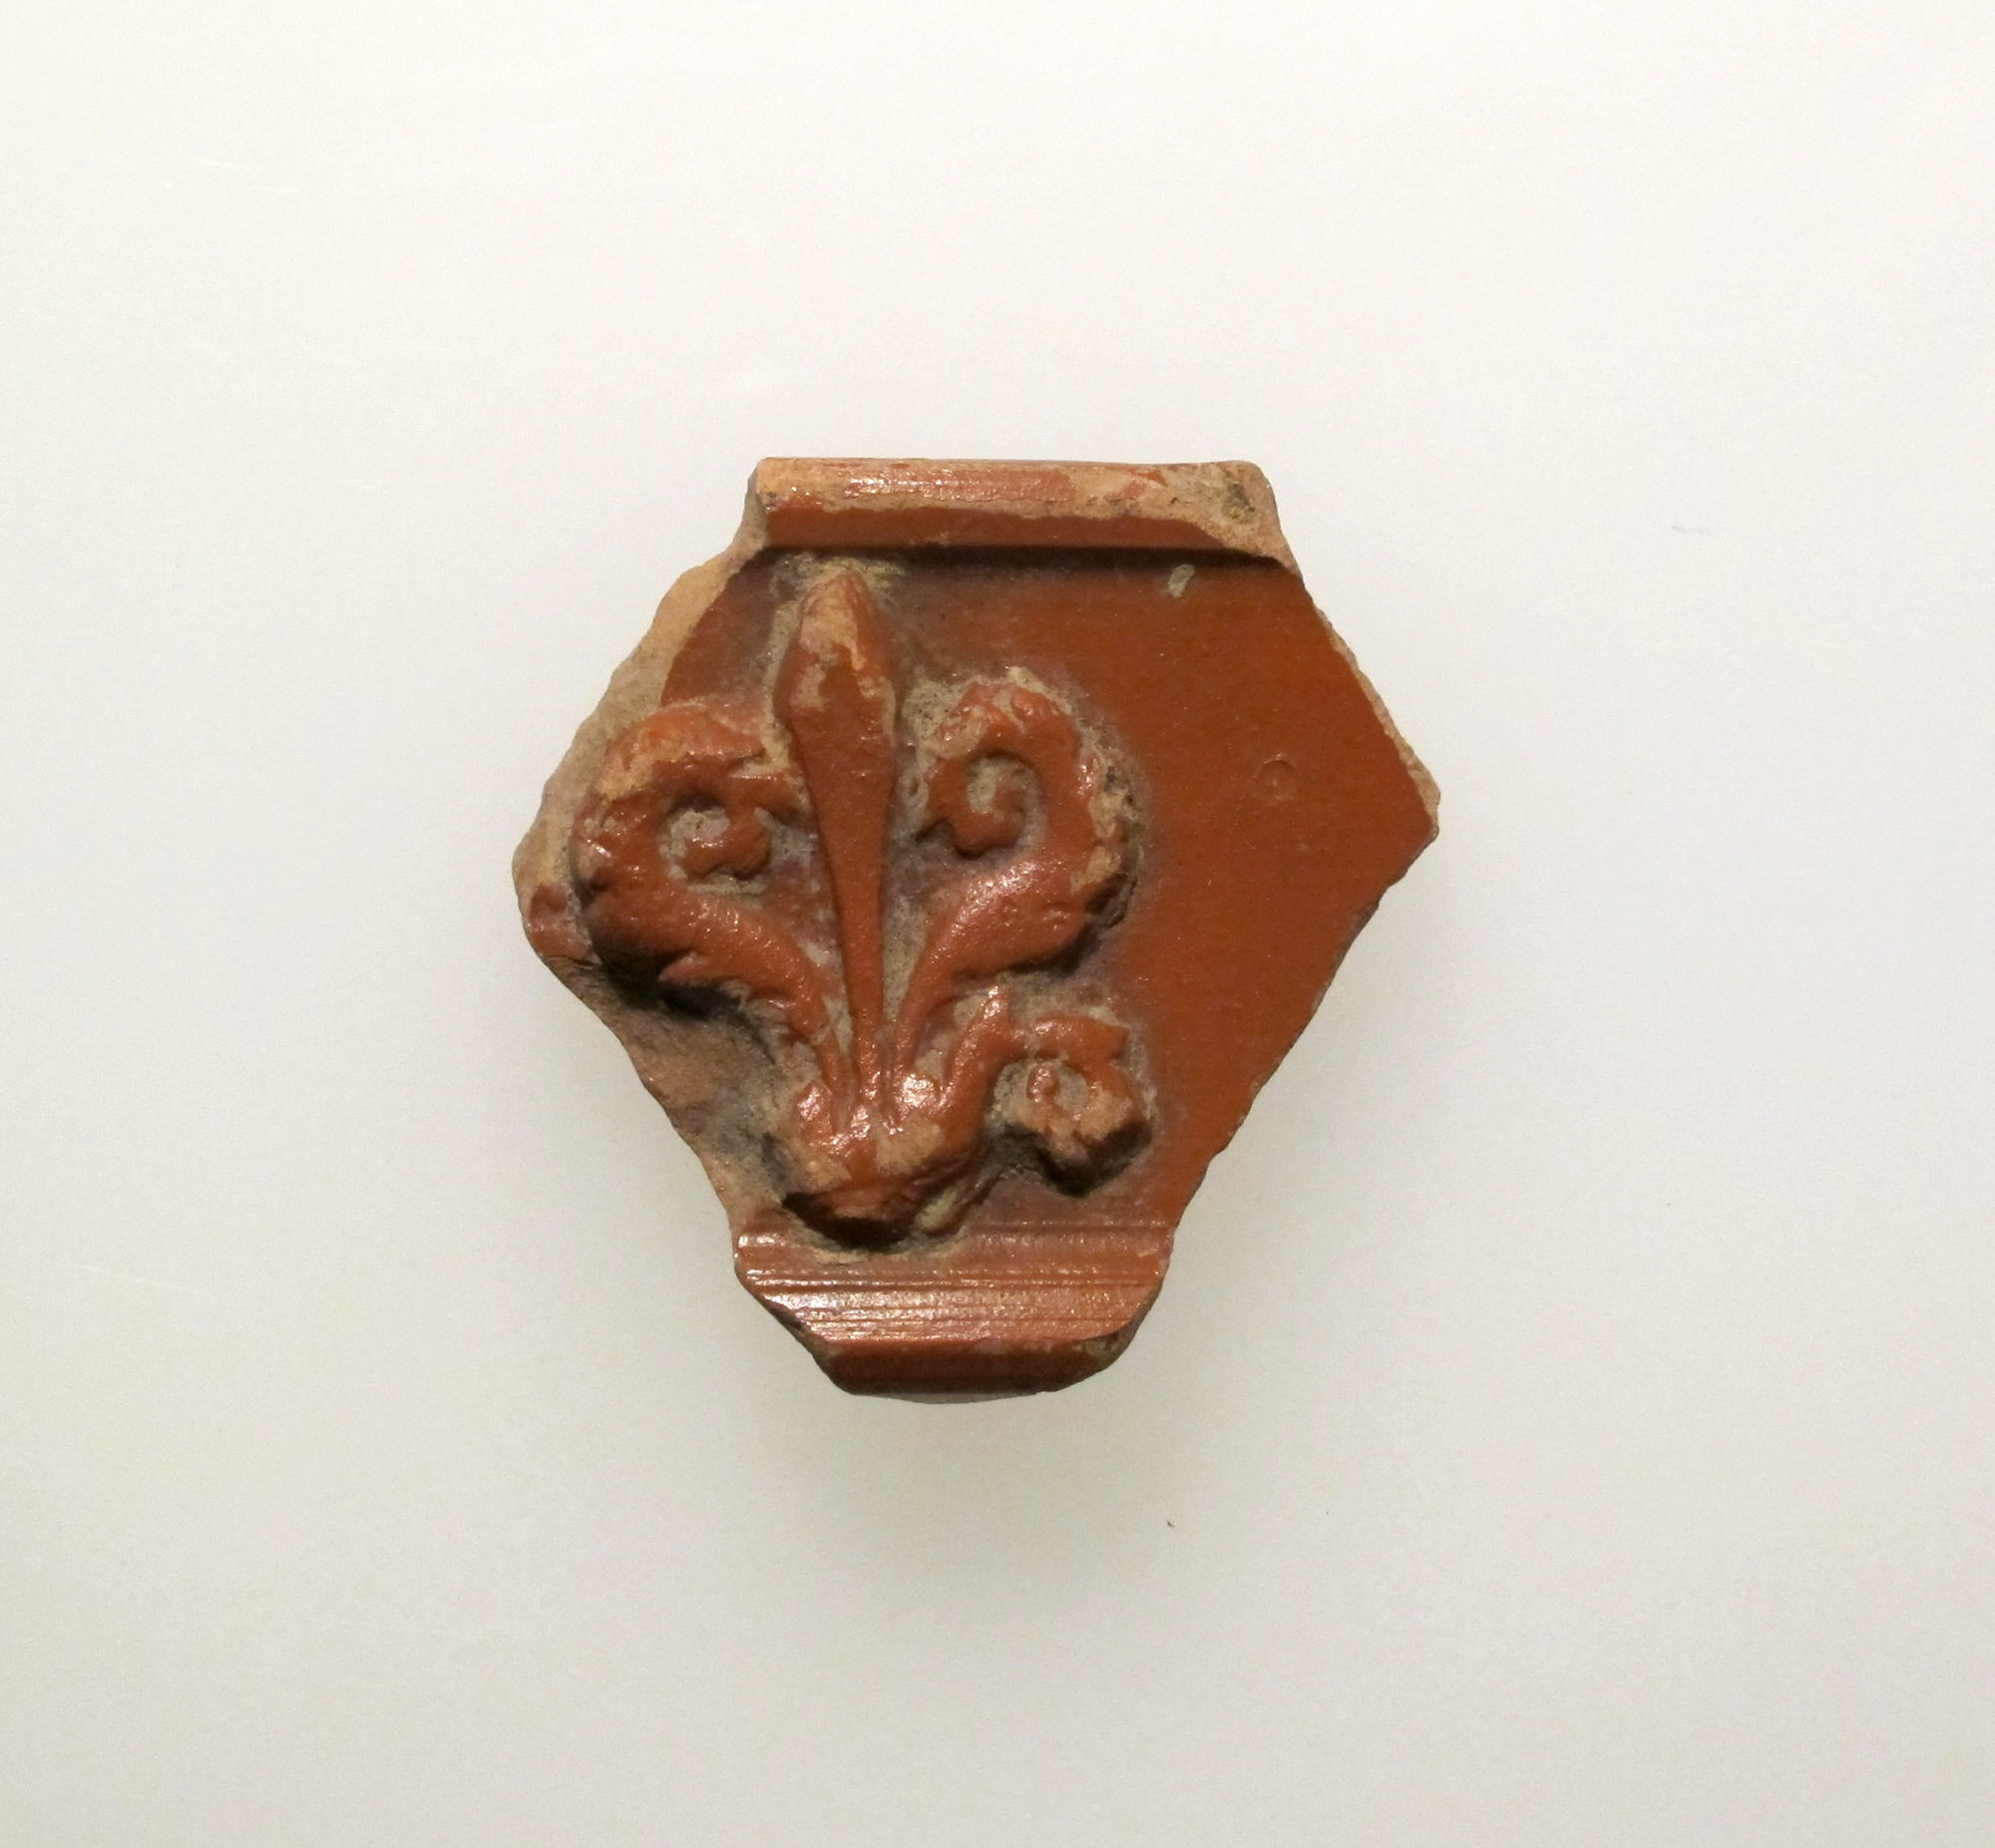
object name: vase fragment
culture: roman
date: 100 BCE-100 CE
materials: terracotta